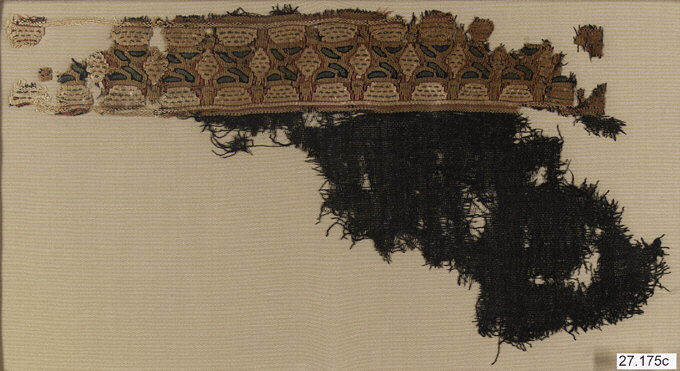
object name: textile fragment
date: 801-900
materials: silk, wool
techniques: weave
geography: egypt